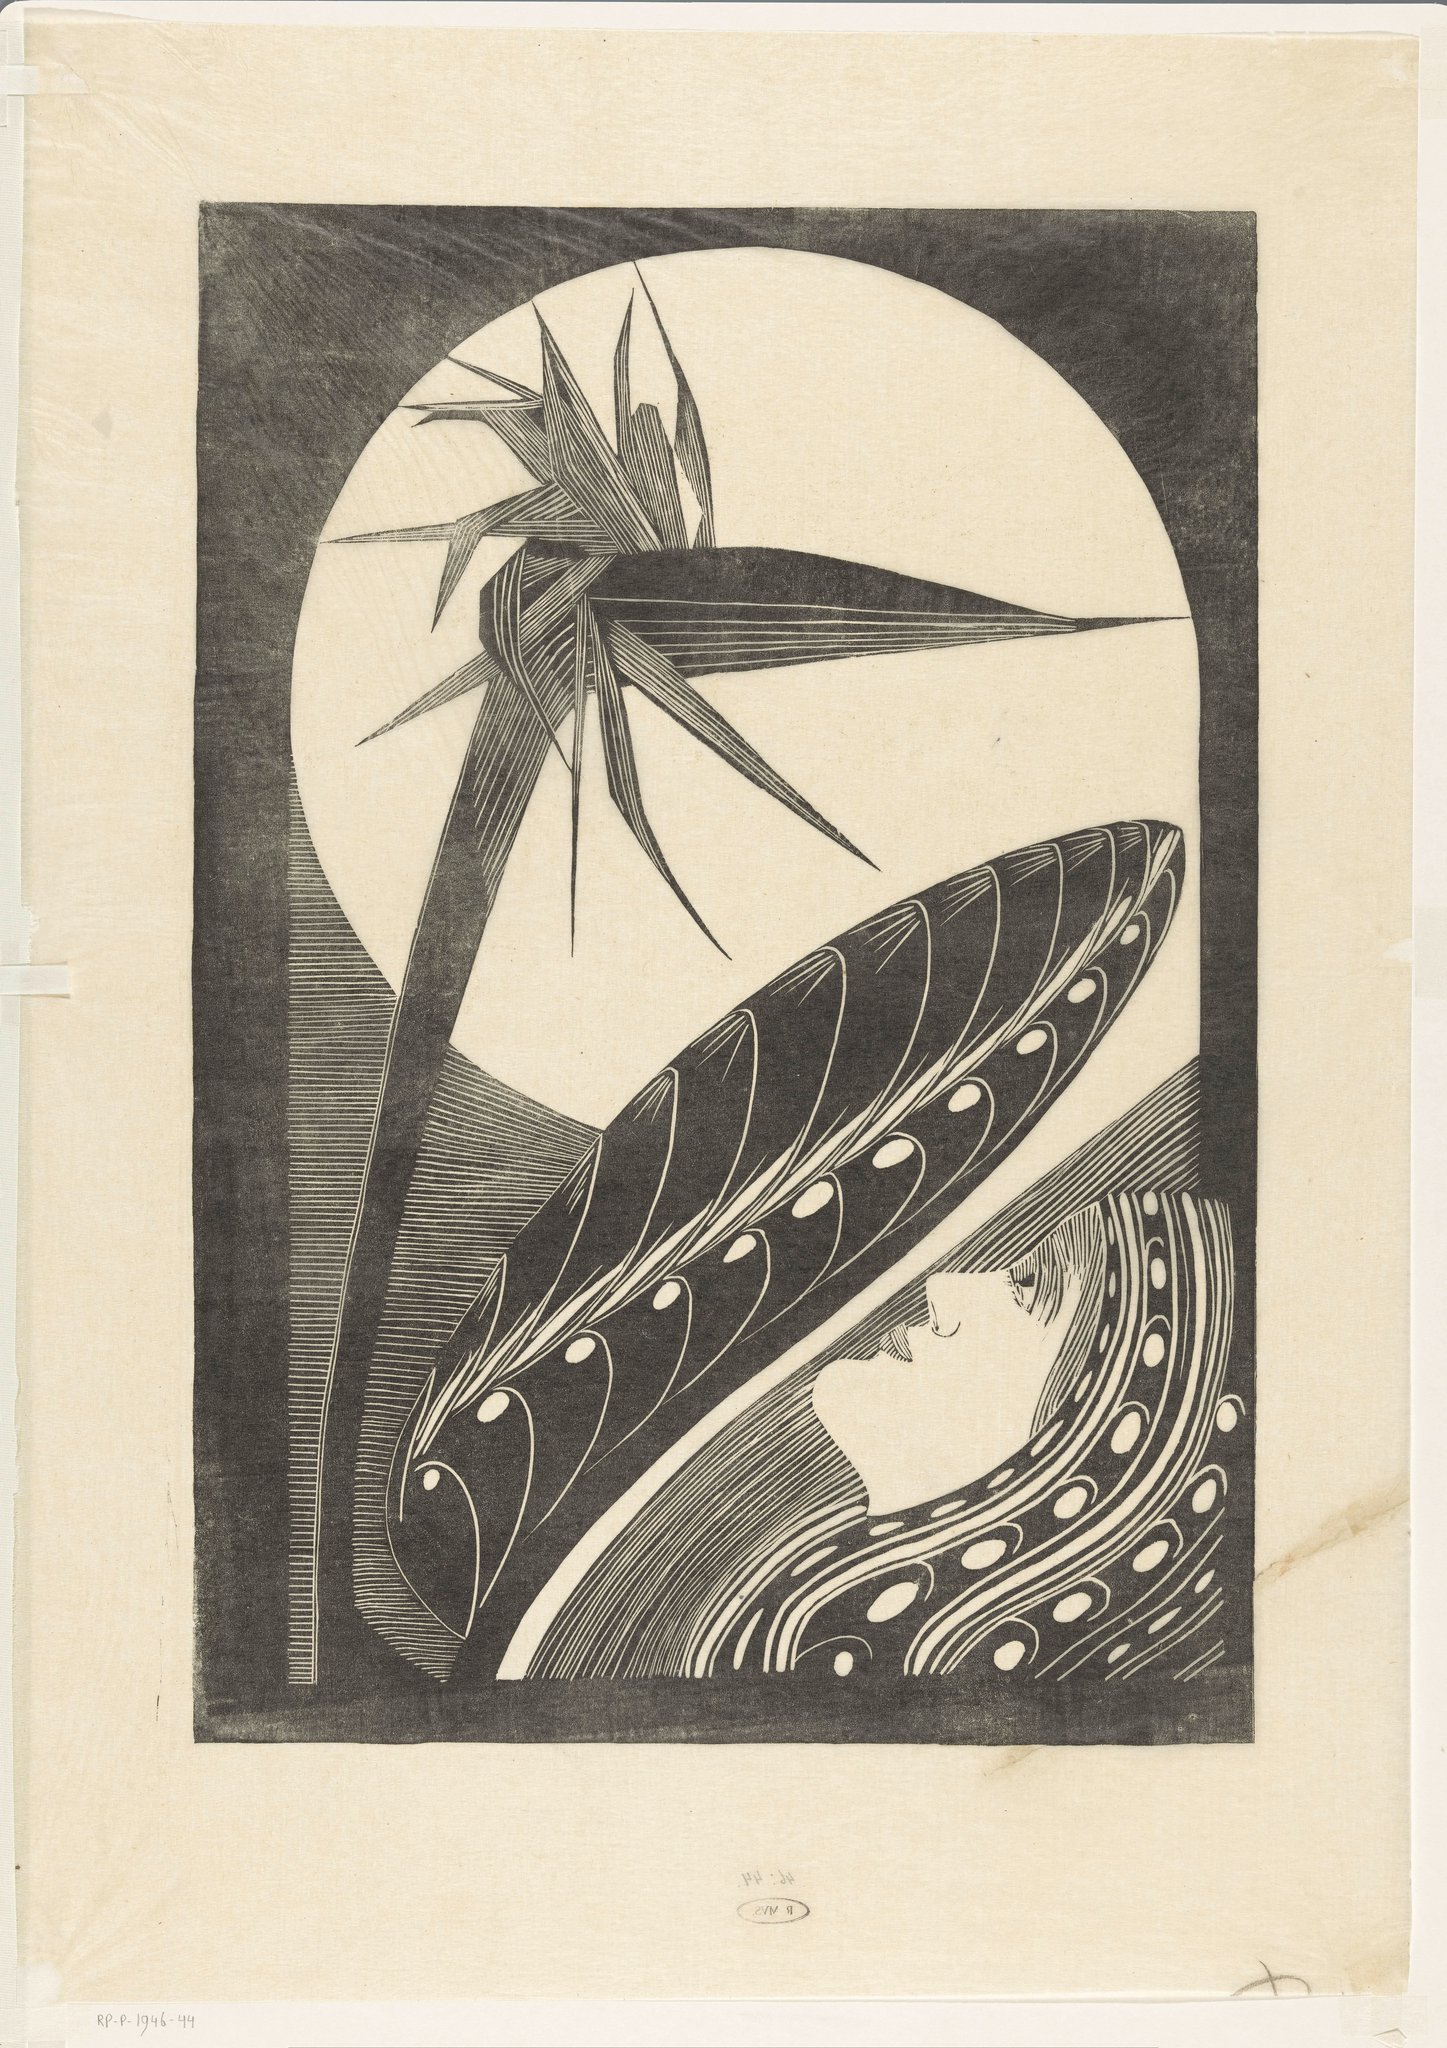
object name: print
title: Uitgebloeide strelitzia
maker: samuel jessurun de mesquita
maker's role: draughtsman, print maker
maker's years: 1868-1944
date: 1934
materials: paper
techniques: woodcut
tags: flowers, face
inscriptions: collector's mark: Lugt 2228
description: Rechtsonder het gezicht van een vrouw en profil.